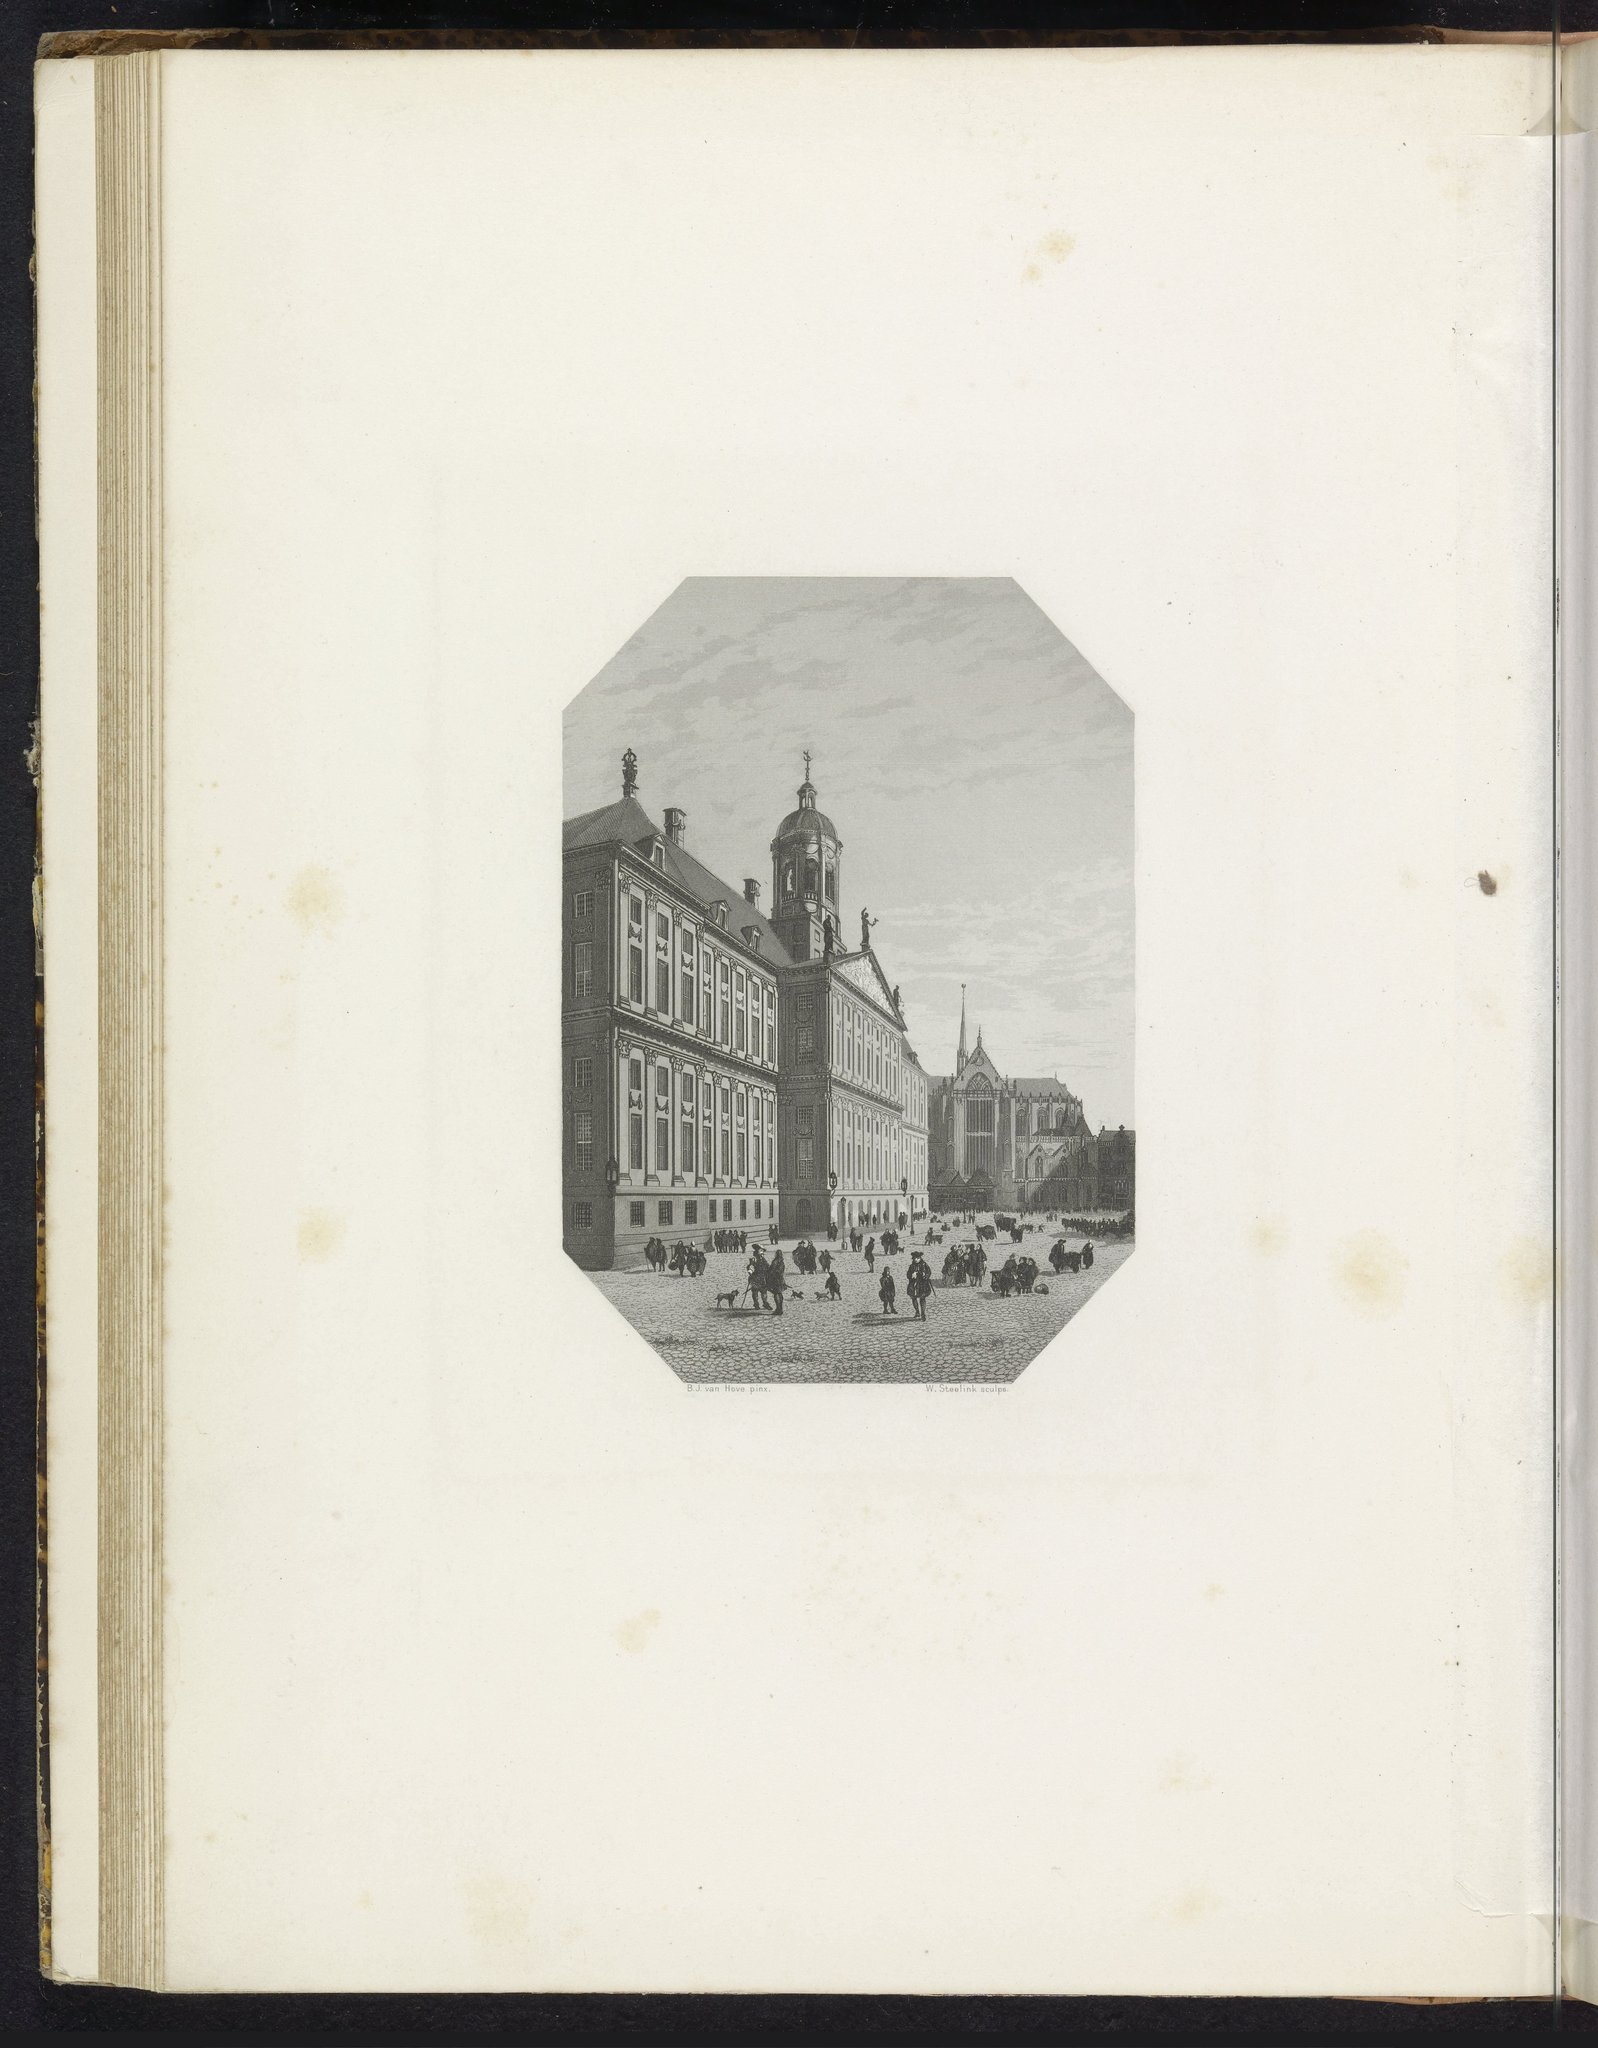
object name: print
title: Stadhuis van Amsterdam, ca. 1670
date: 1865-1870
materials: paper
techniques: engraving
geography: netherlands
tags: townhall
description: Gezicht op het nieuwe stadhuis op de Dam te Amsterdam, in gebruik genomen in 1655. Voorgesteld in voltooide staat, met toren. ca. 1670. Onderdeel van de groep staalgravures naar de schilderijen van de Historische Galerij der Maatschappij Arti et Amicitiae.